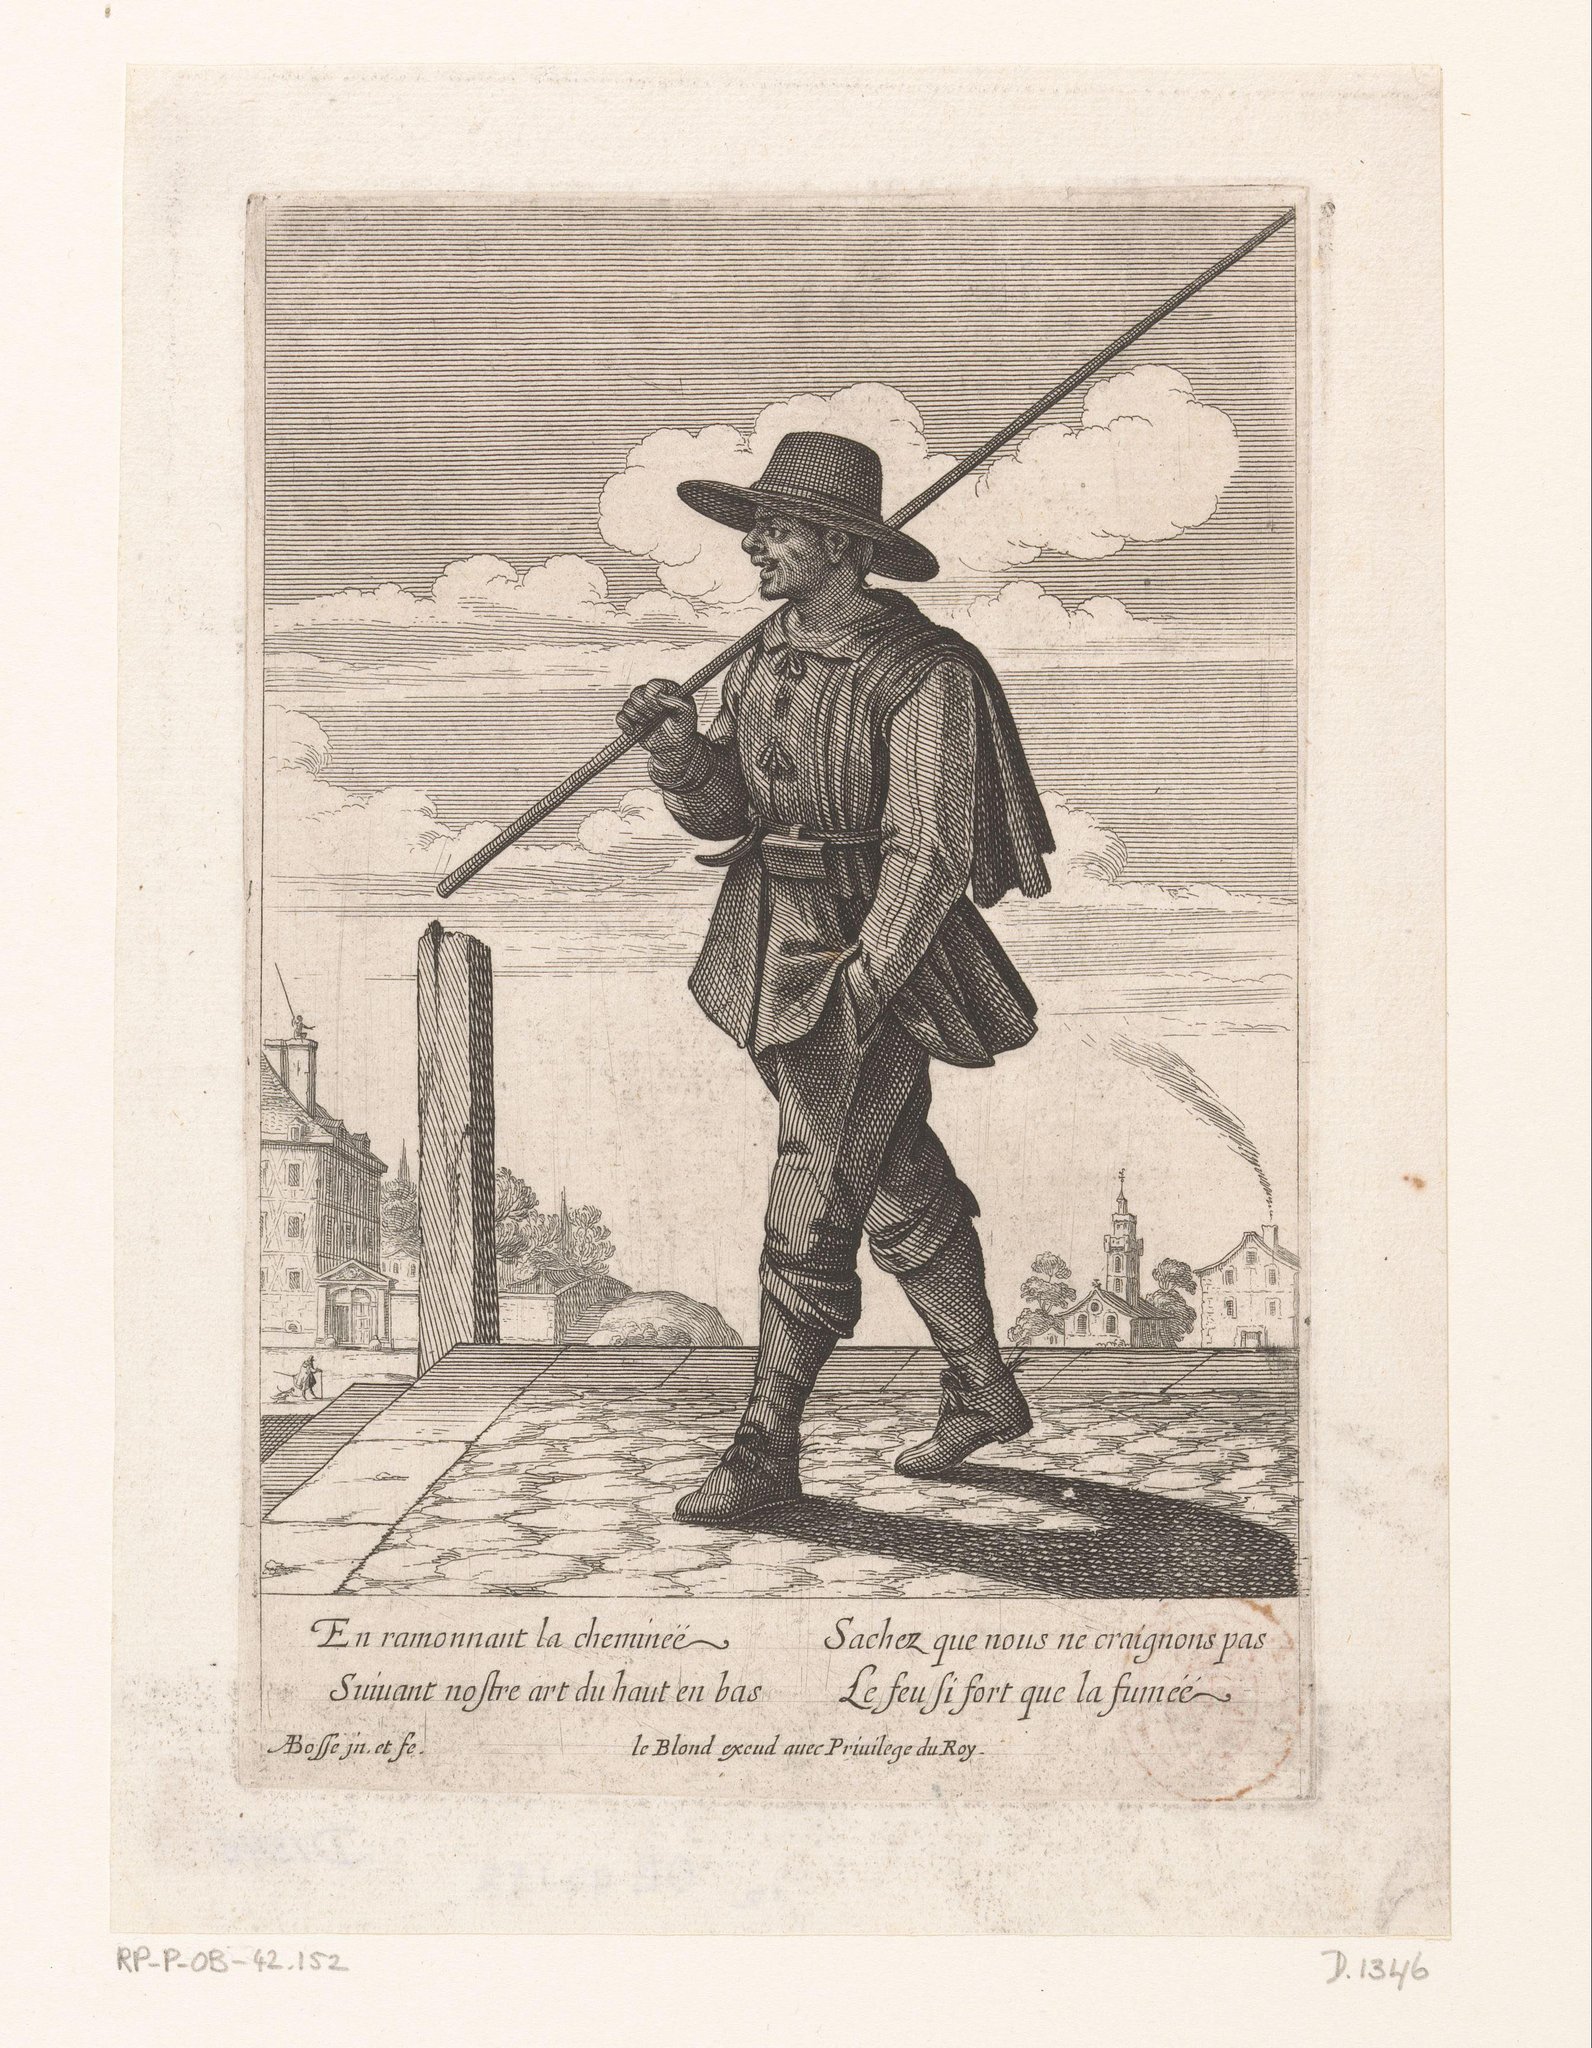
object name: print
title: Straatverkopers en dienstverleners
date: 1629-1630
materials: paper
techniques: engraving, etching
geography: paris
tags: wandering or travelling merchant, handicrafts ~ maintenance and repair (with name of trade or profession), merchant, salesman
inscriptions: collector's mark: Lugt 240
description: Maakt deel uit van een serie van twaalf prenten met straatverkopers en dienstverleners, uitgegeven door Jean Leblond (I) tussen 1629-1630 te Parijs.